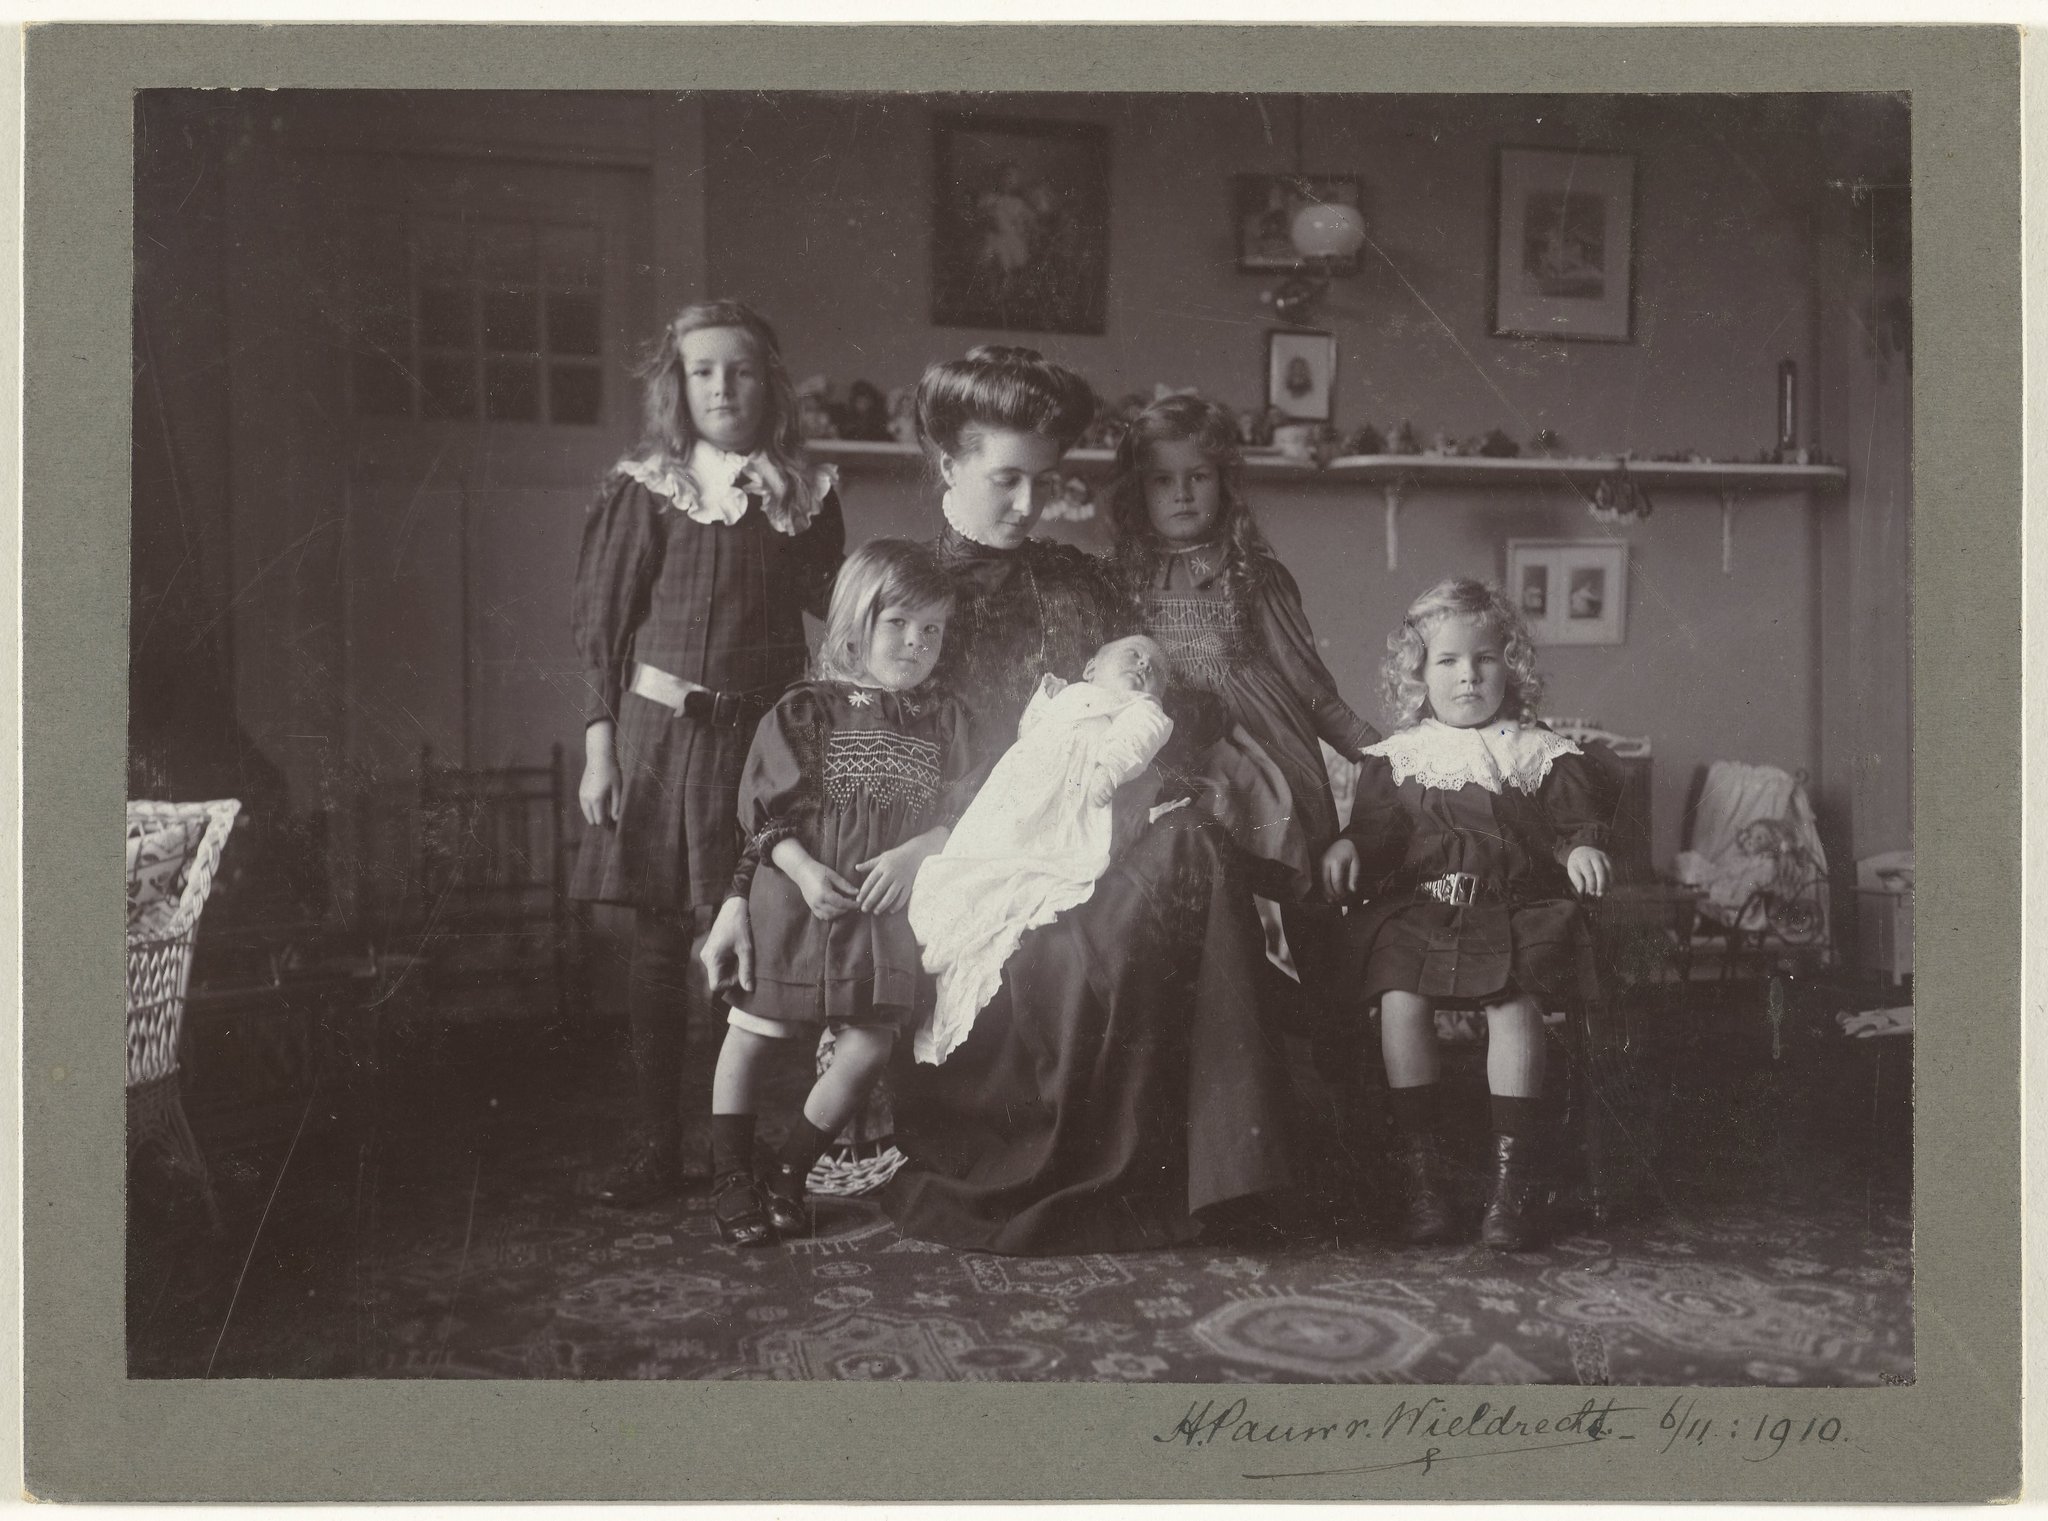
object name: photograph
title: Portret van de vijf kinderen van de fotograaf (Sacha, Renée, Dorothée, Thelma, en Irène) met een nanny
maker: henry pauw van wieldrecht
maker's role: fotograaf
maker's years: 1863-1912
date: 1910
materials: cardboard, photographic support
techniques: collodion silver print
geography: netherlands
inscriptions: annotation: ‘Barroness R. van Tuyll van Serooskerken. / Rubensstraat 63 / Amsterdam. / Holland.’, annotation: ‘Irène / Baby / Nanny / Renée / Thelma / Sacha’, signature and date: ‘H. Pauw v. Wieldrecht 6/11:1910.’